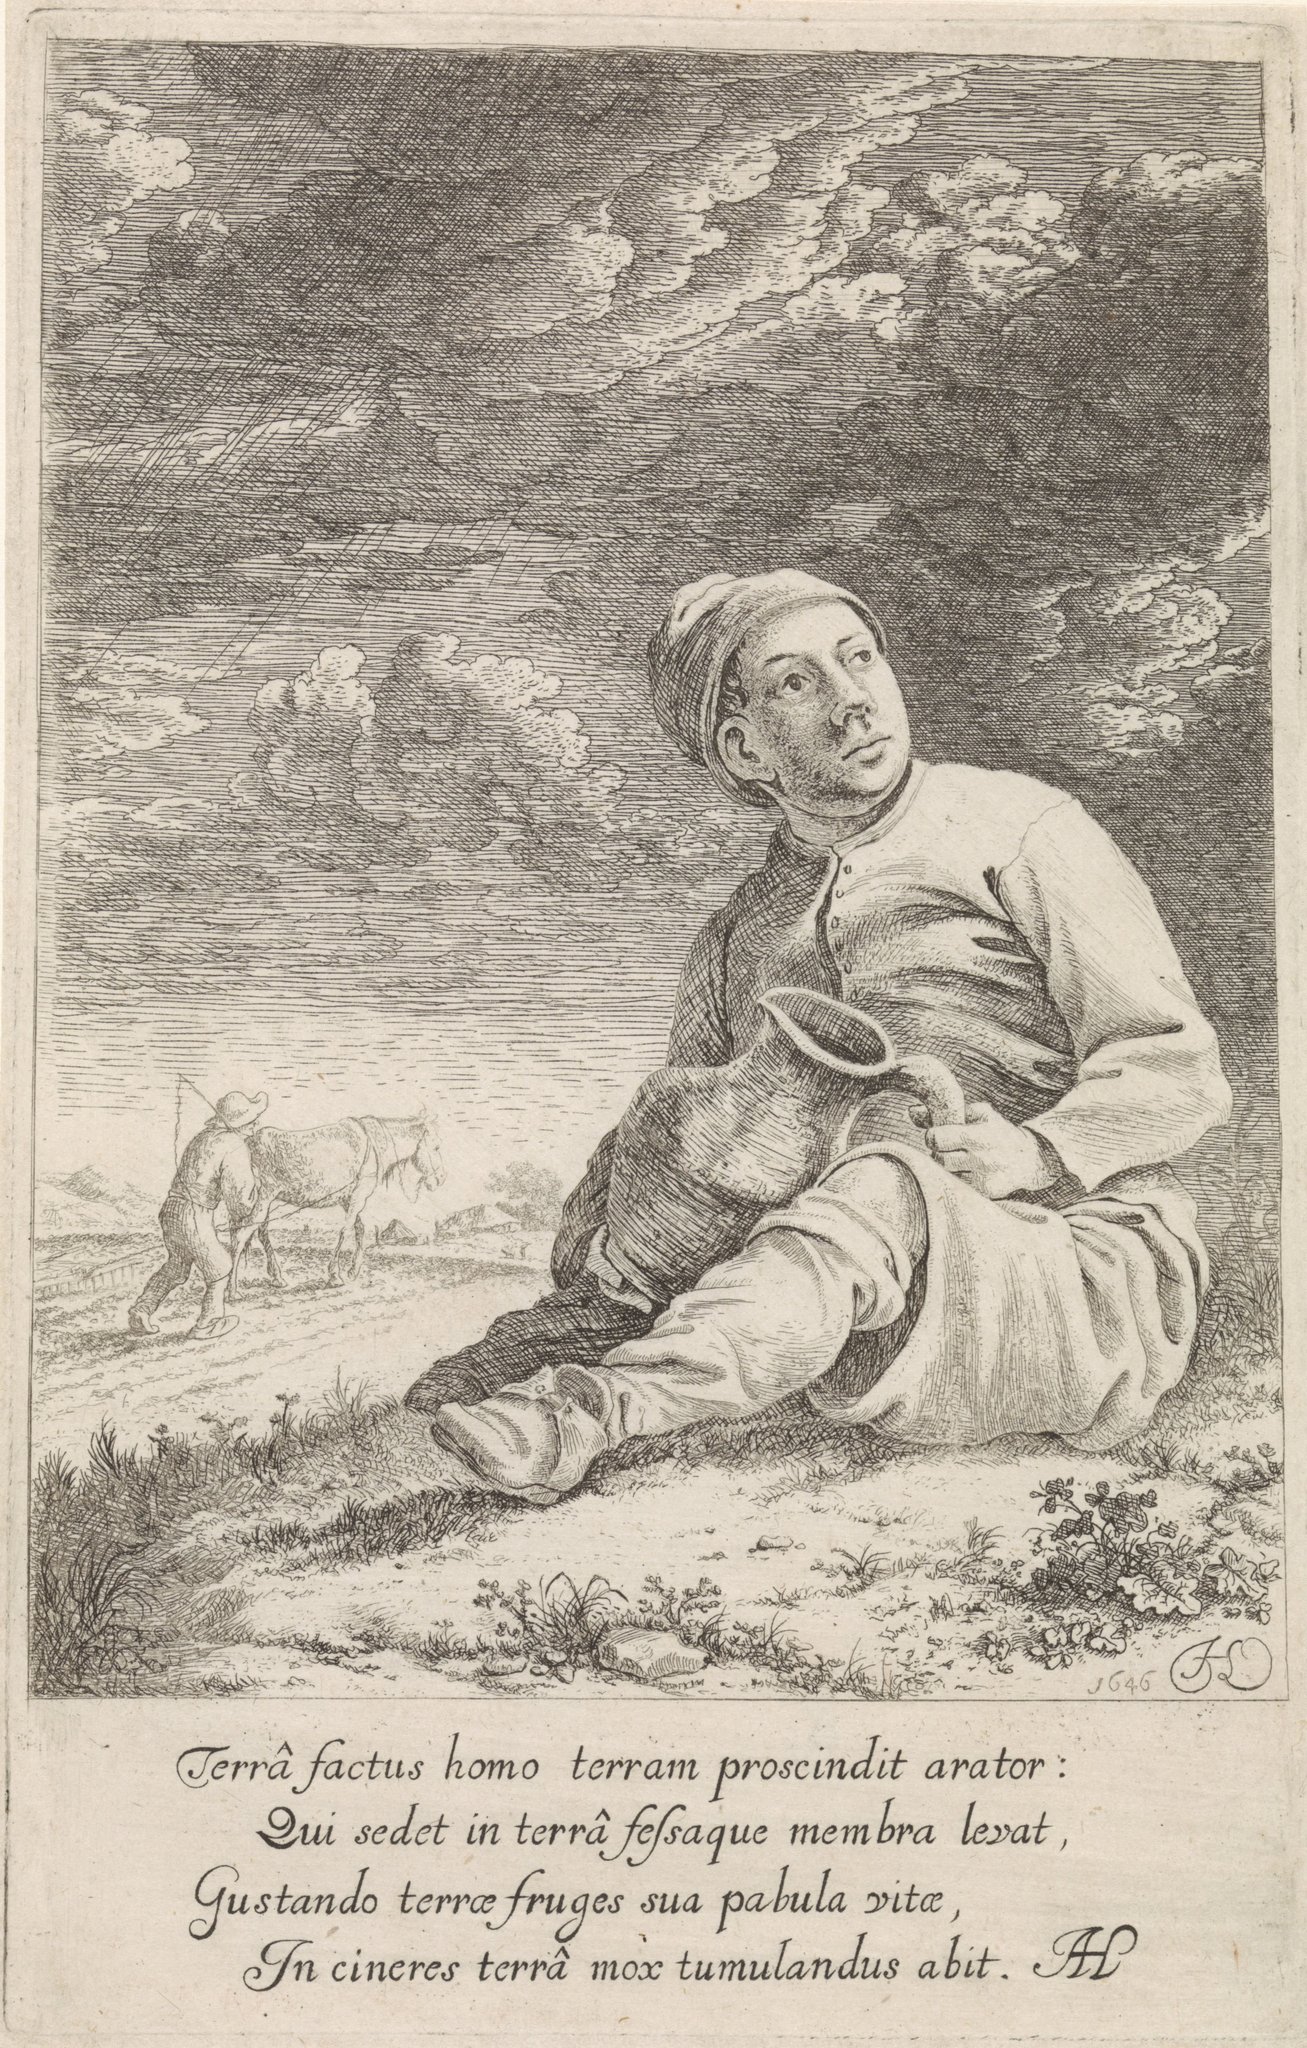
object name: print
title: Zittende boer met een kruik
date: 1646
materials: paper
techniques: etching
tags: ploughed field, jar, jug (used as drinking-vessel), farmers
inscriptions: date: ‘1646’, monogram: ‘HSL’, caption: ‘Terra...abit’, collector's mark: Lugt 240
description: Boerenjongen met mutsje op en een kruik in de handen, zittend op de grond. Op de achtergrond een boer die het land ploegt.